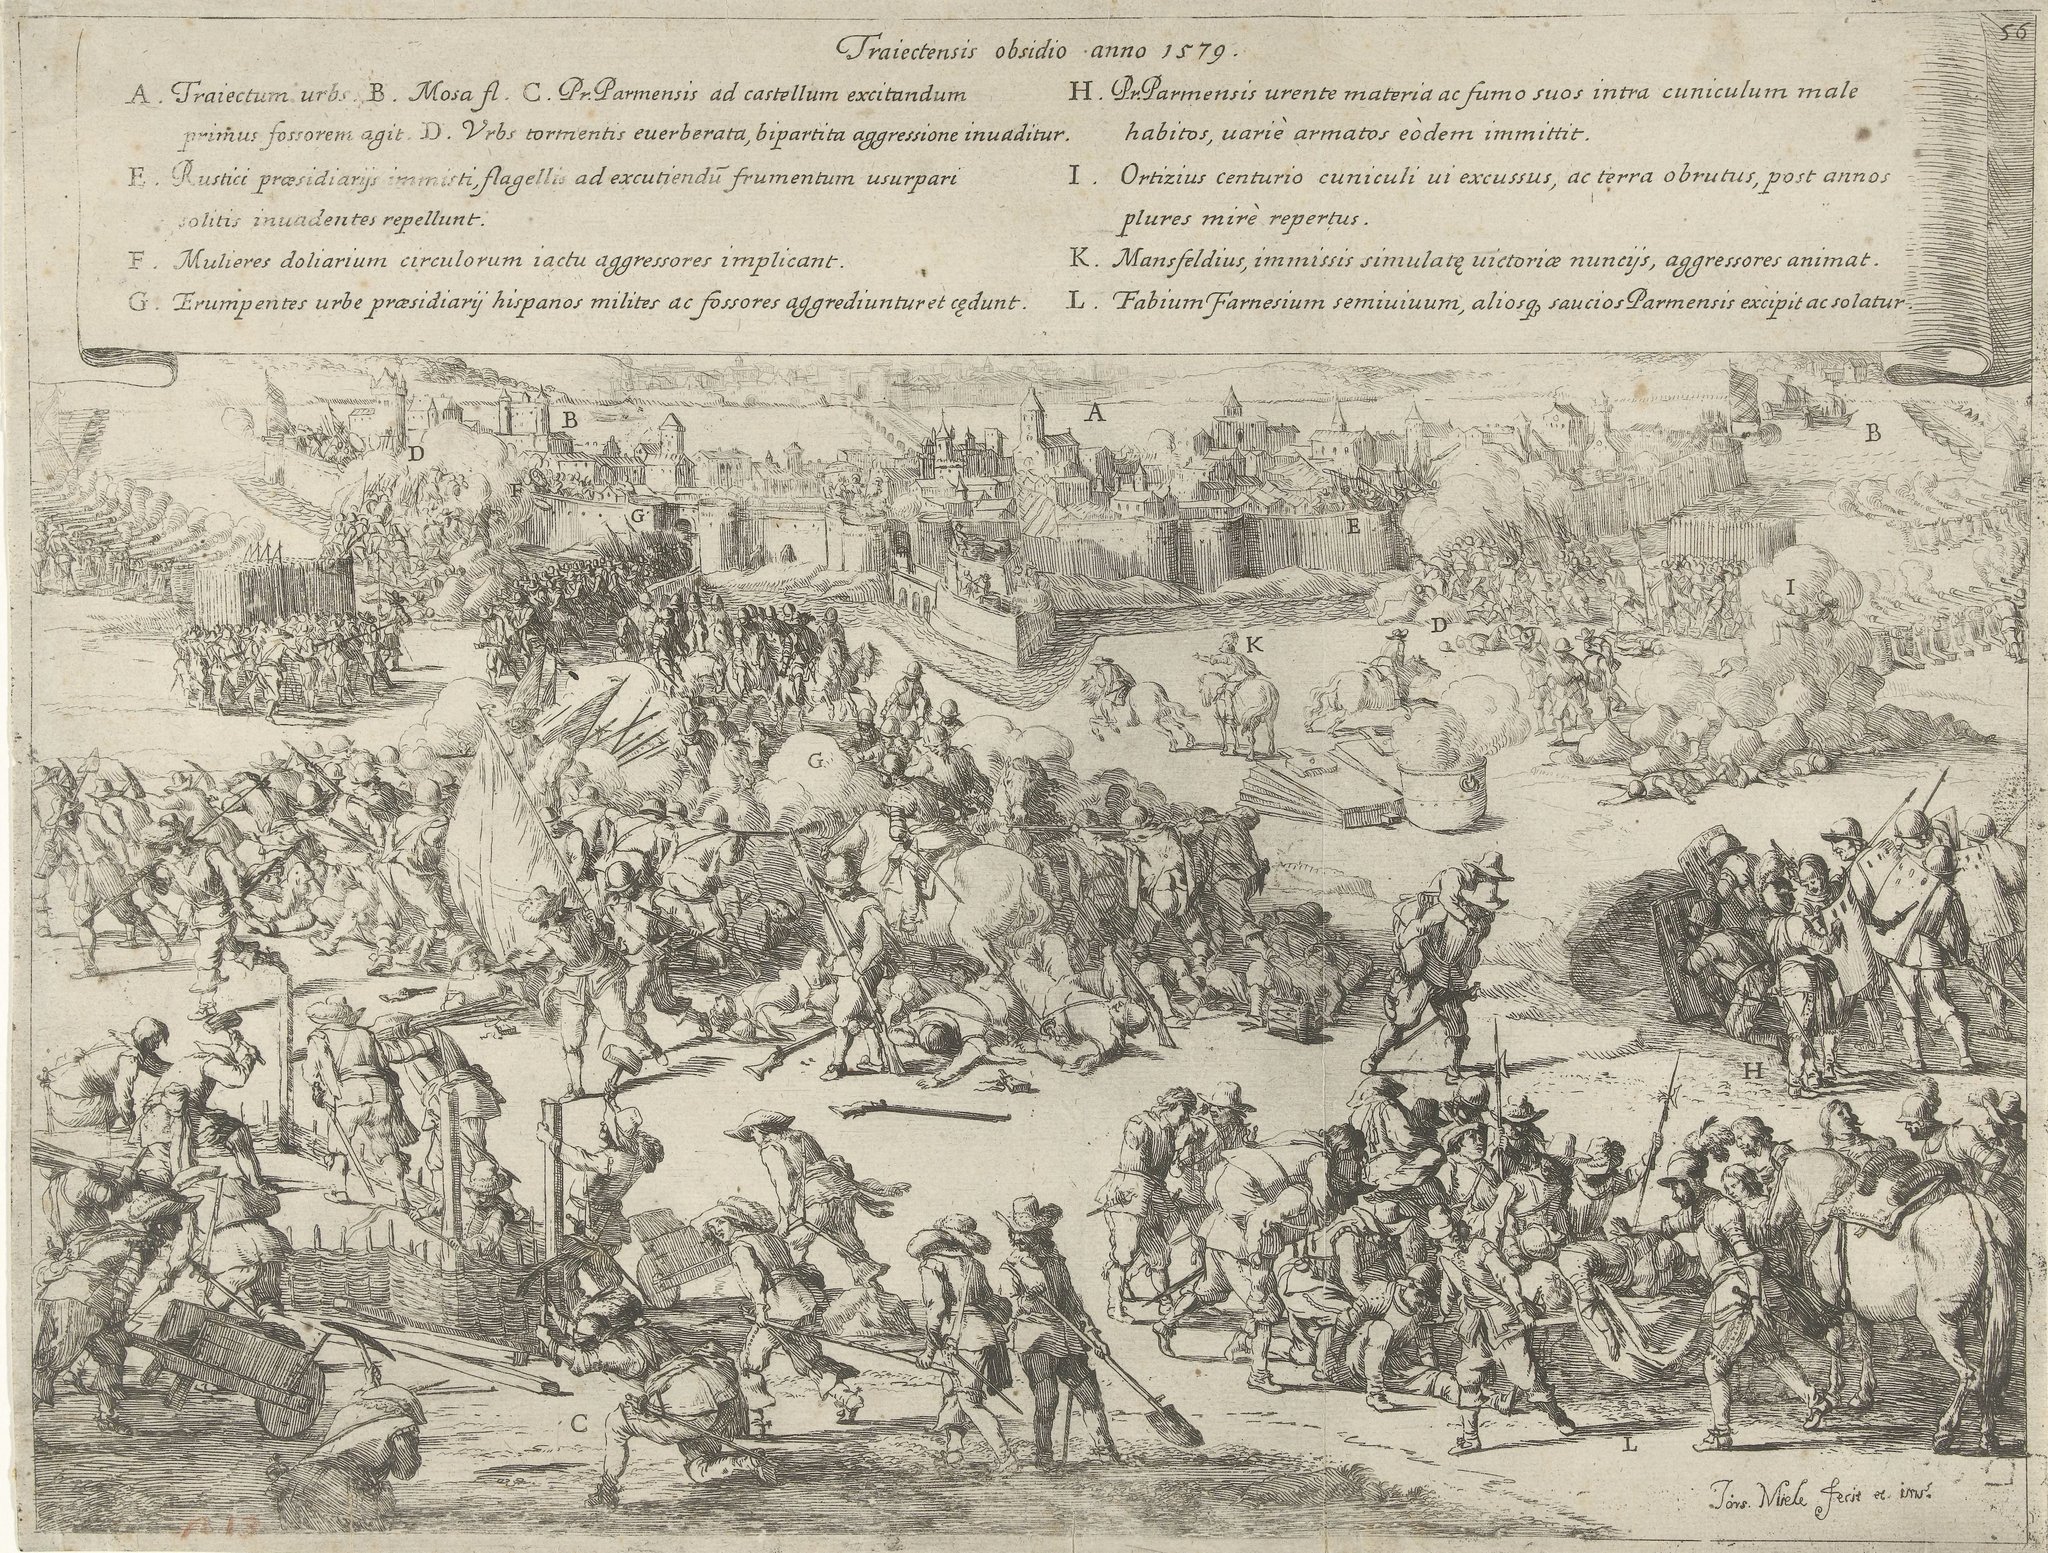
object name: print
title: Beleg van Maastricht, 1579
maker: jan miel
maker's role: draughtsman, painter, print maker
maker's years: 1599-1663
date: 1645-1647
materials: paper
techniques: etching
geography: rome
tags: siege, position war, fortifications, military engineering, maastricht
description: Belegering van Maastricht door het leger van de hertog van Parma, van 12 maart tot 29 juni 1579. Gezicht op de stad, het bouwen van schansen, gevechten voor de stad en het afvoeren van gewonden. Bovenaan een banderol met de titel en de legenda A-L in het Latijn.